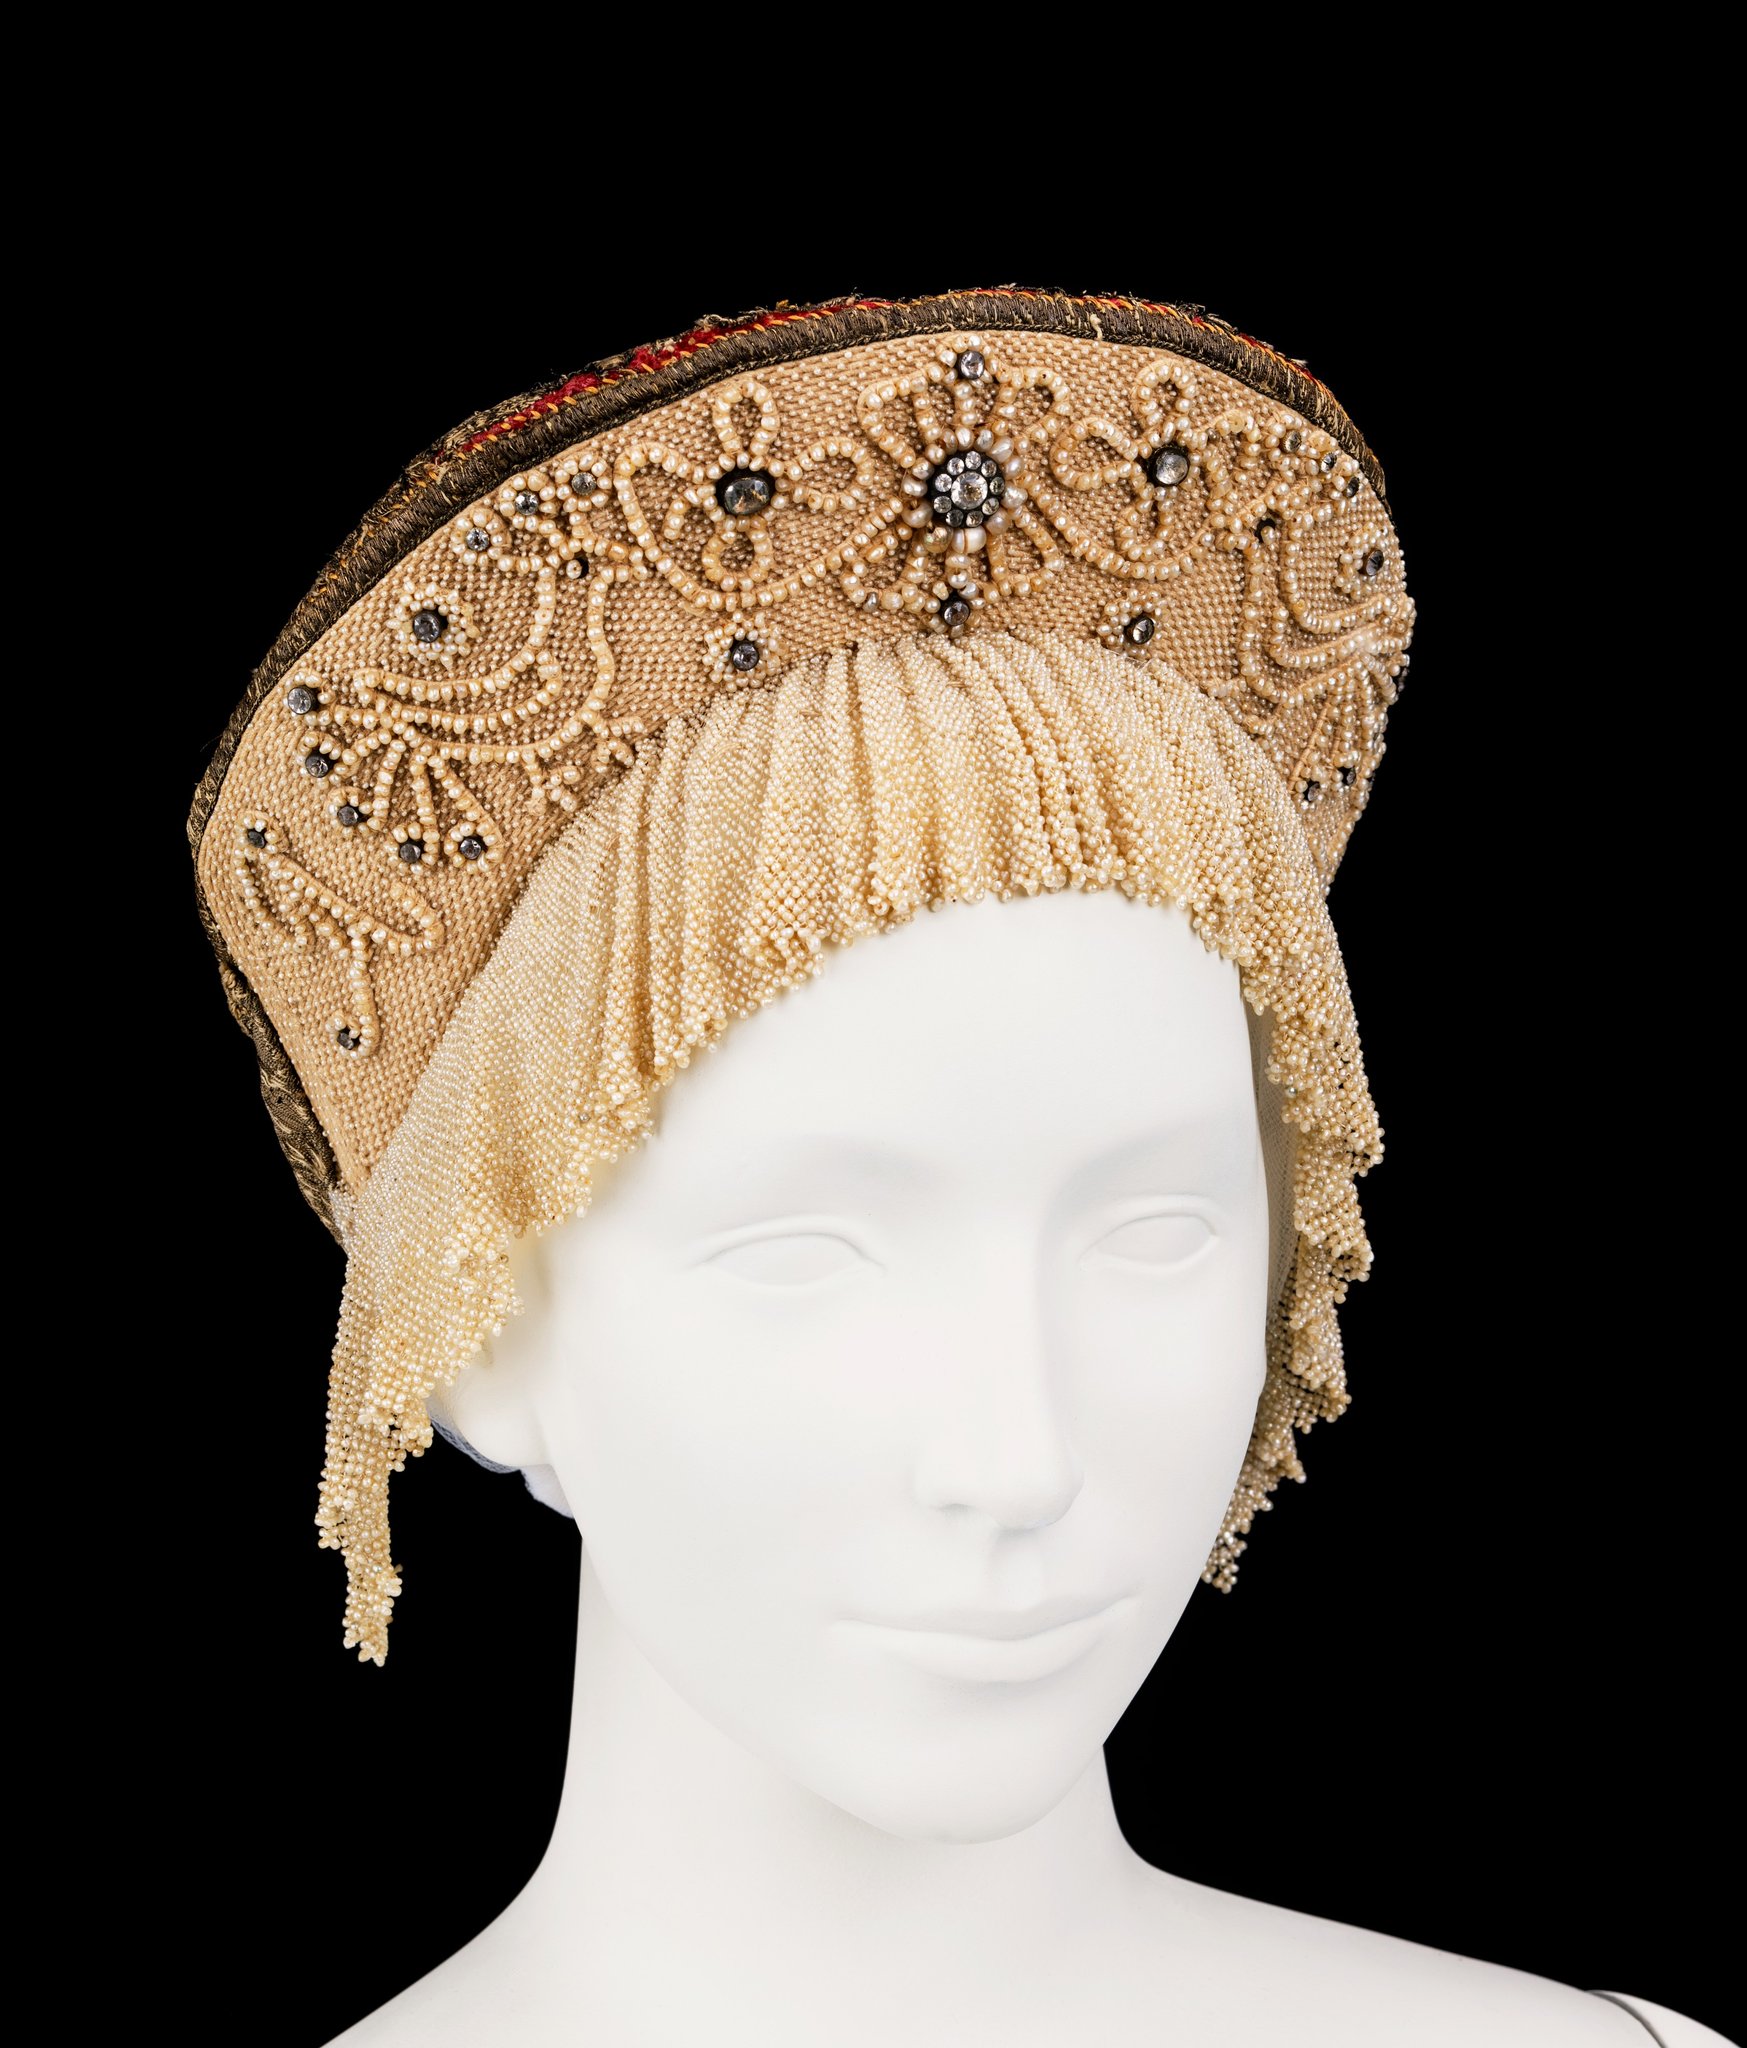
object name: headdress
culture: russian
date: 1790-1810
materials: cotton, glass, metal, pearl, silk